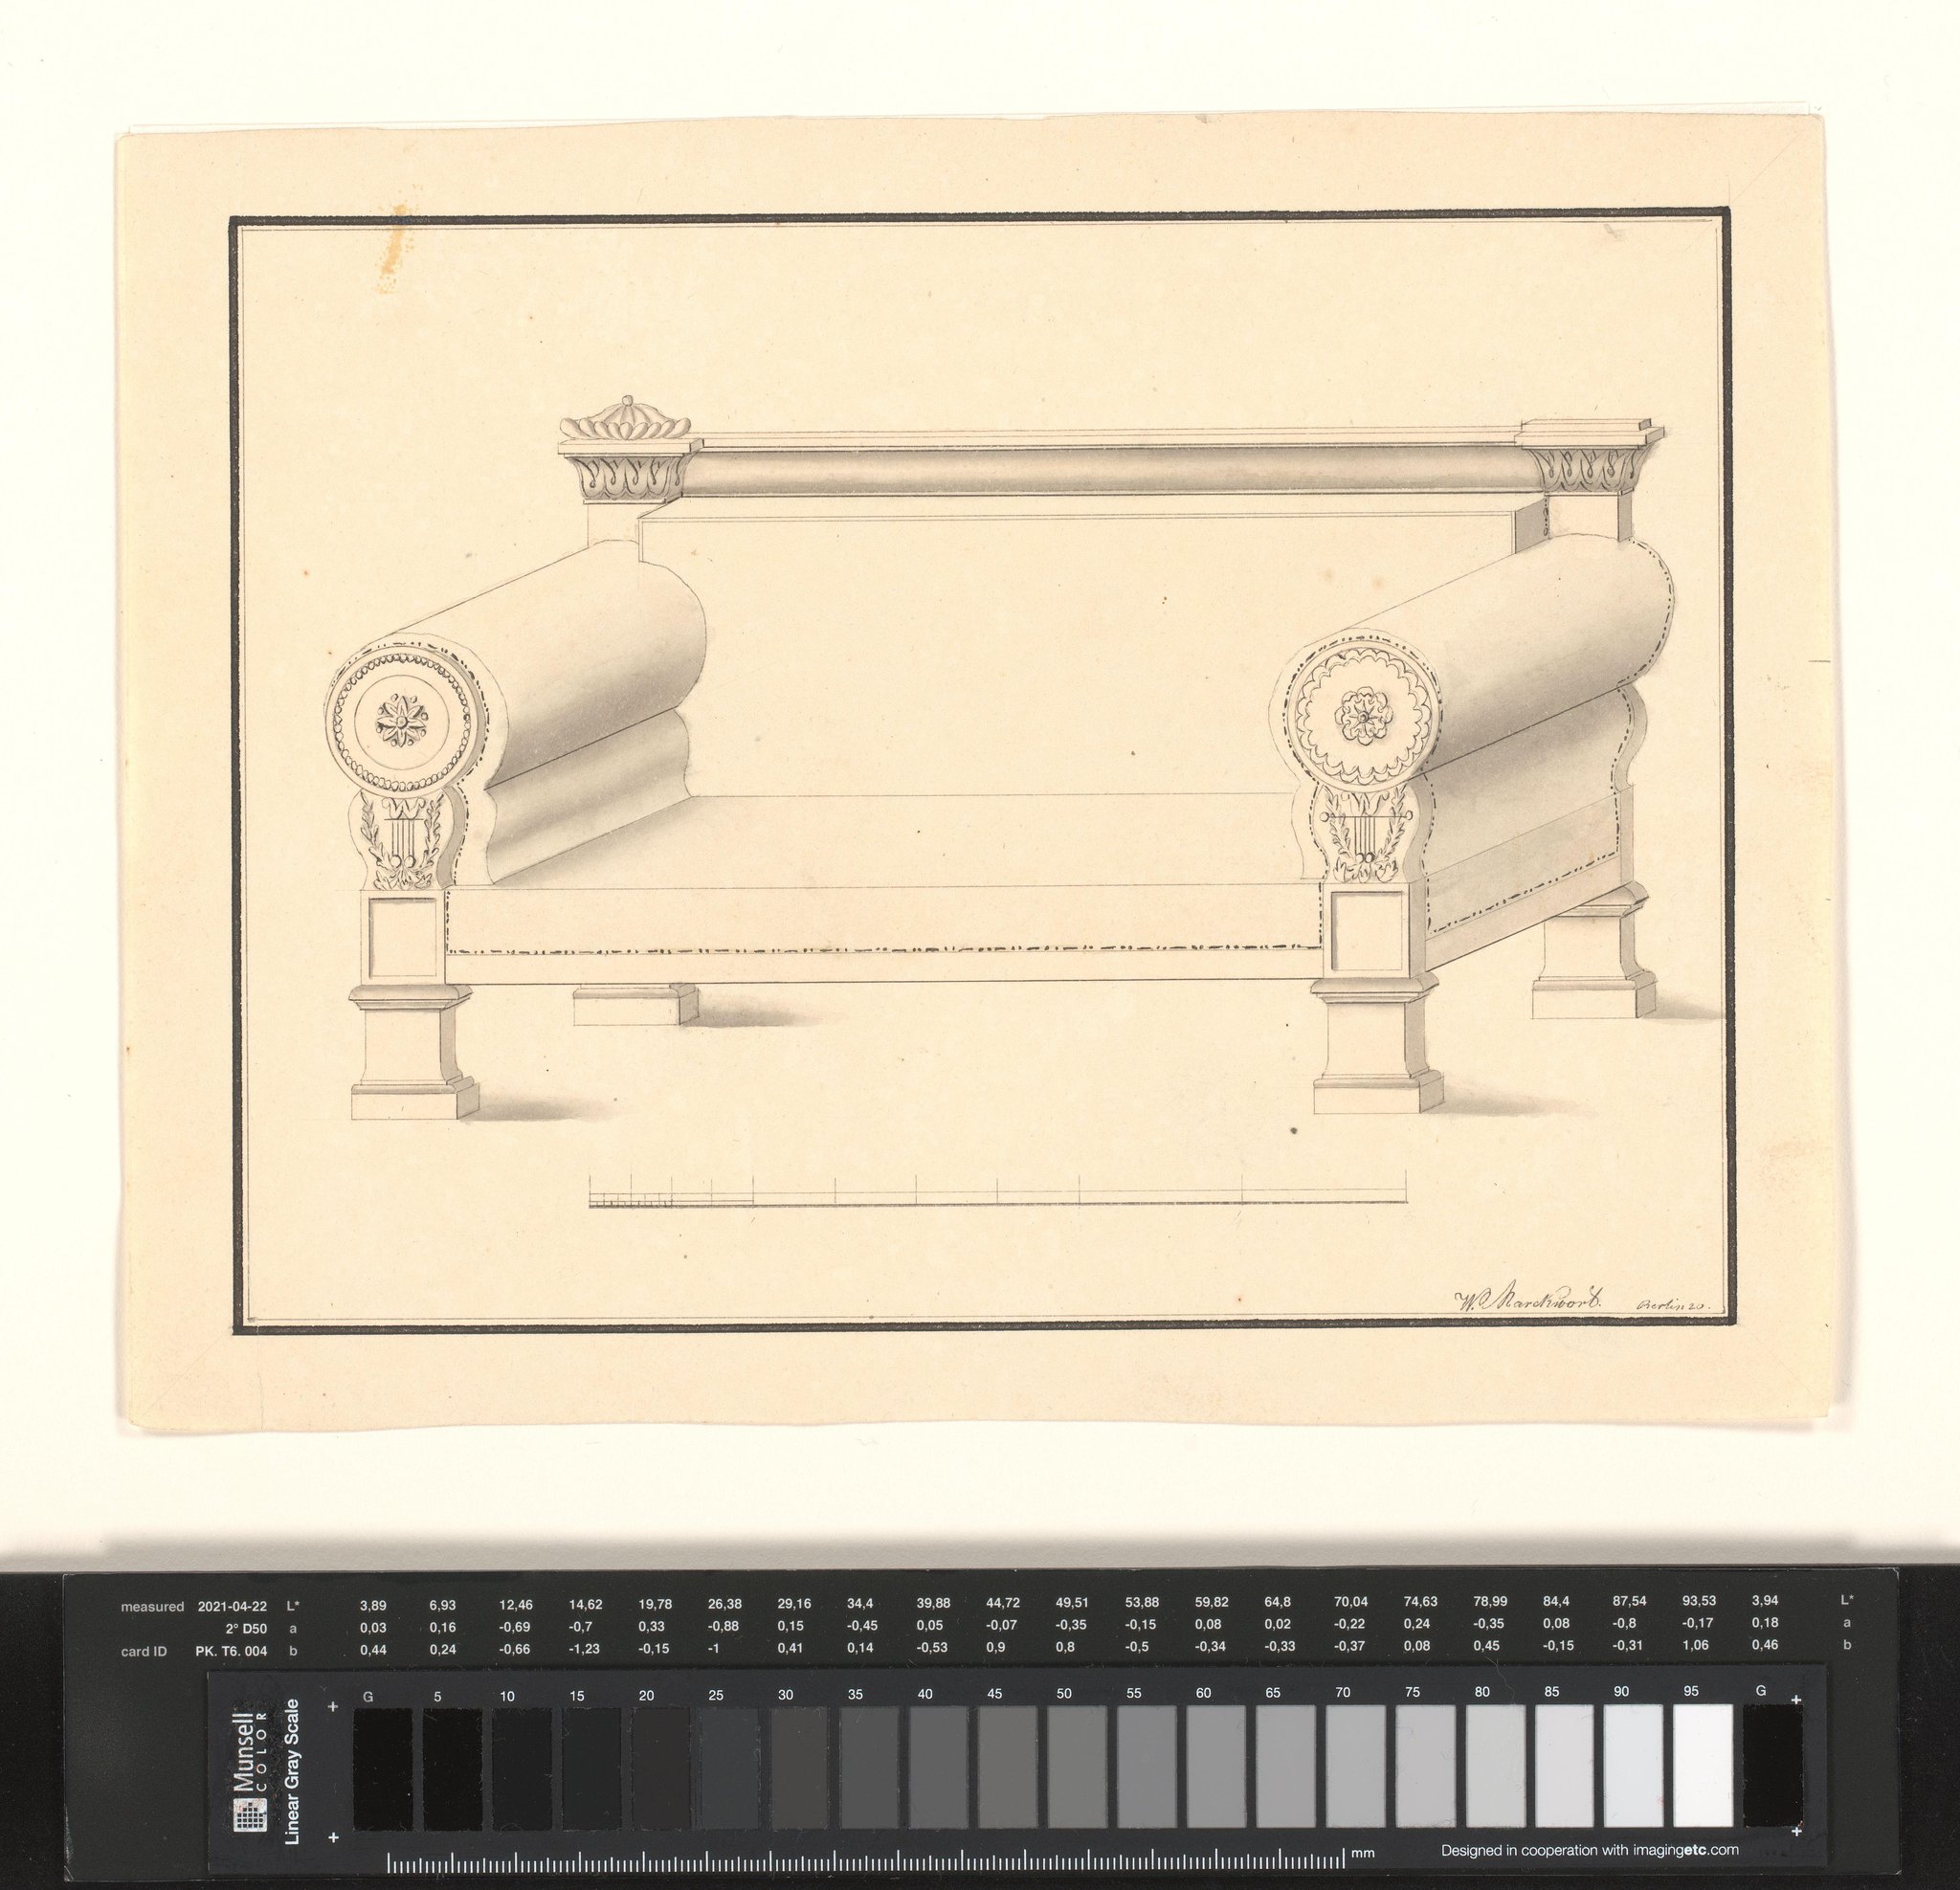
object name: design drawing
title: Ontwerp voor een beklede canapé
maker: carl wilhelm marckwort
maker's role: draughtsman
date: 1820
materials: ink, paper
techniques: brush, pen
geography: berlin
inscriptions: signature and date: ‘W.Marckwort. Berlin 20’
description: Beklede canapé met cylindrische armleuningen, met daaronder een maatverdeling.